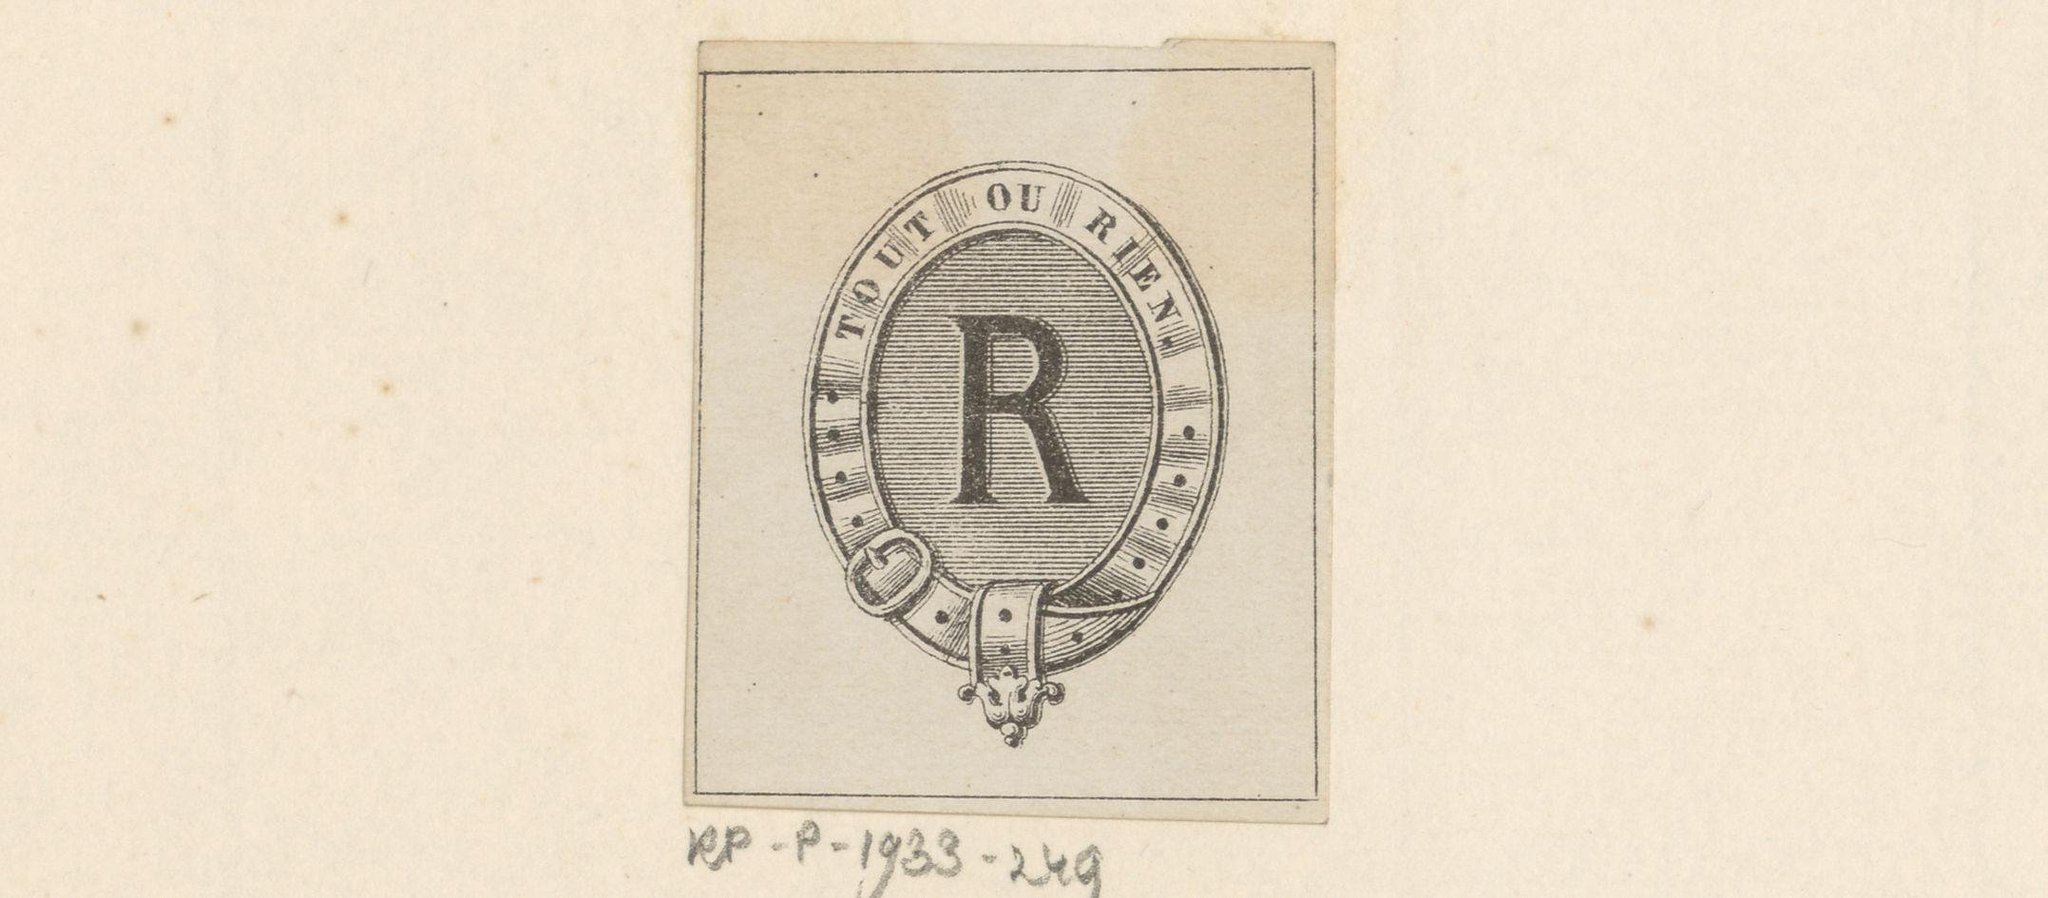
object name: bookplate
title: Tout ou rien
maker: Anonymous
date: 1880-1933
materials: paper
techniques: lithograph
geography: france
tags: belt, girdle, waistband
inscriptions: collector's mark: Lugt 2760